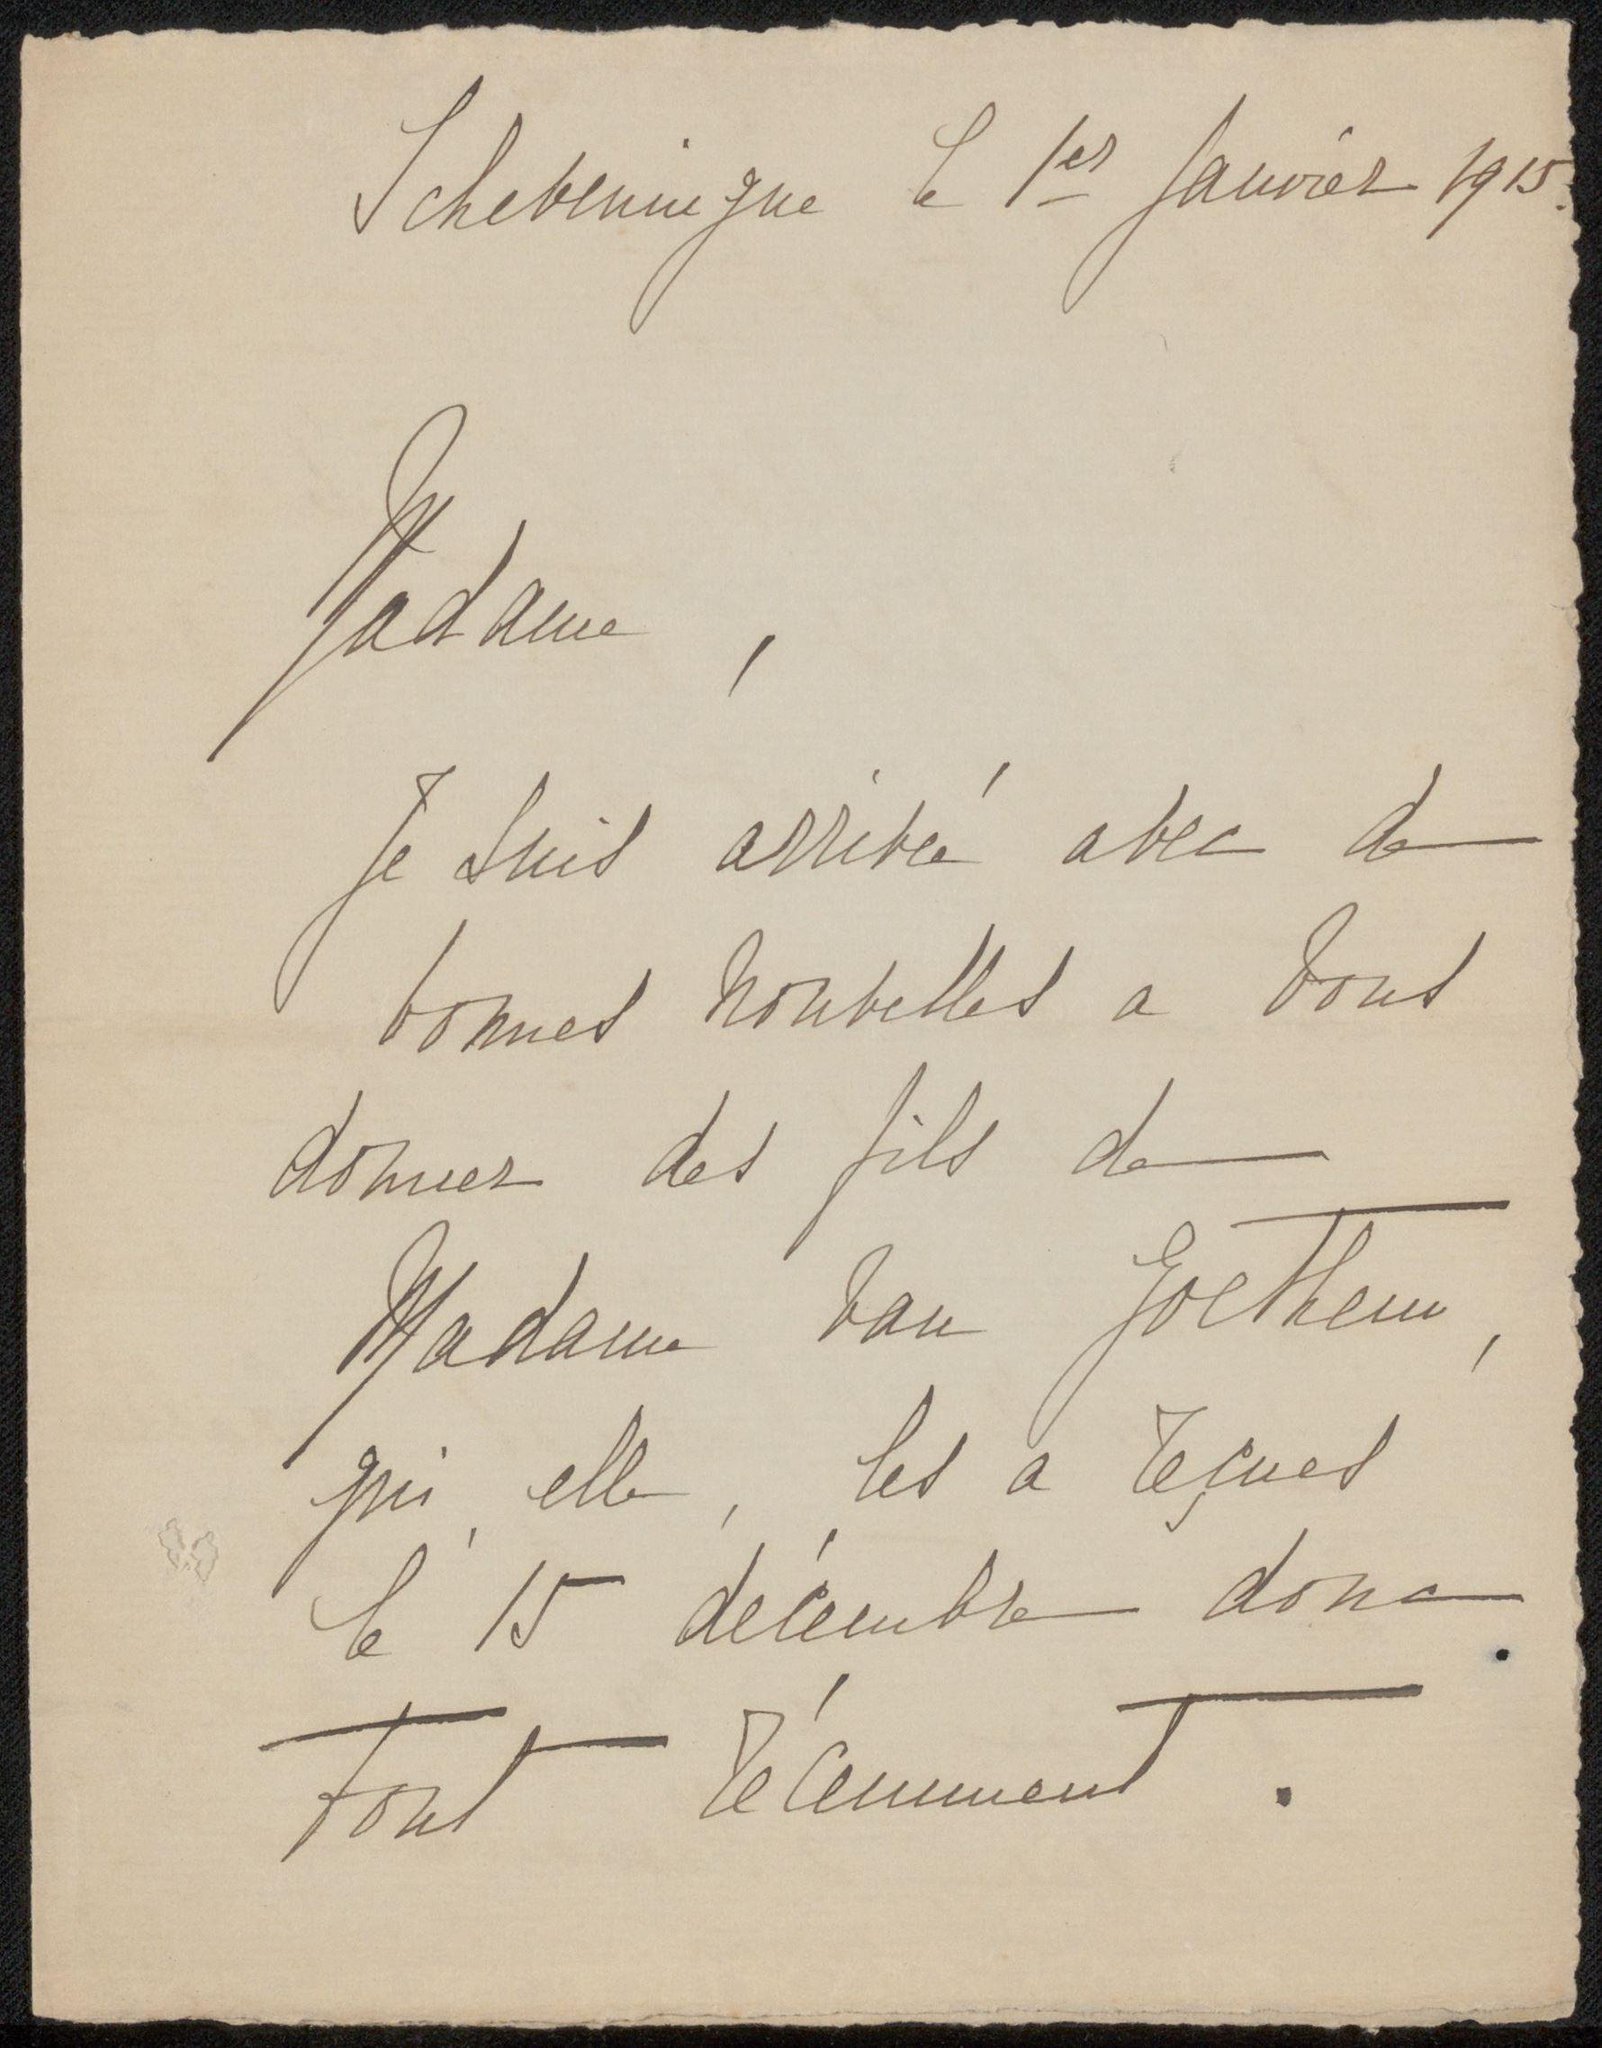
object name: letter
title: Brief aan Henriette Wilhelmina van Baak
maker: germaine wenziner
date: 1915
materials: ink, paper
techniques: pen, writing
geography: scheveningen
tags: henriette wilhelmina van baak, brussels, hélène van goethem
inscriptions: collector's mark: ‘RPK’